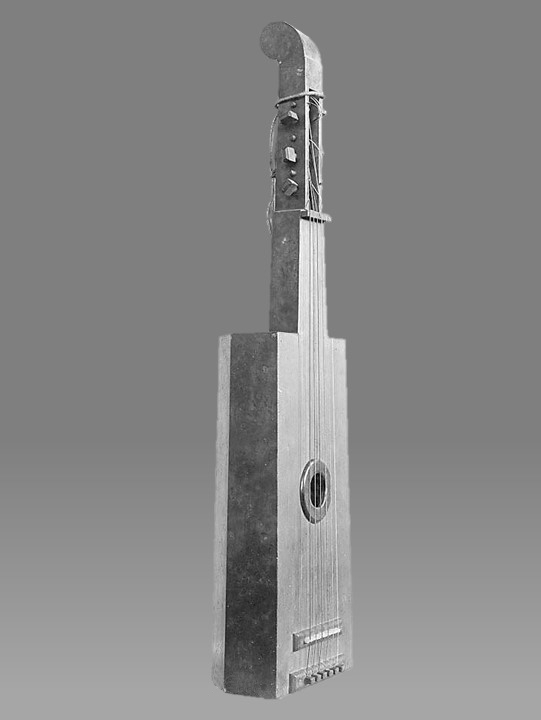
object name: guitar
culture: russian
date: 1801-1833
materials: metal, wood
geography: russia